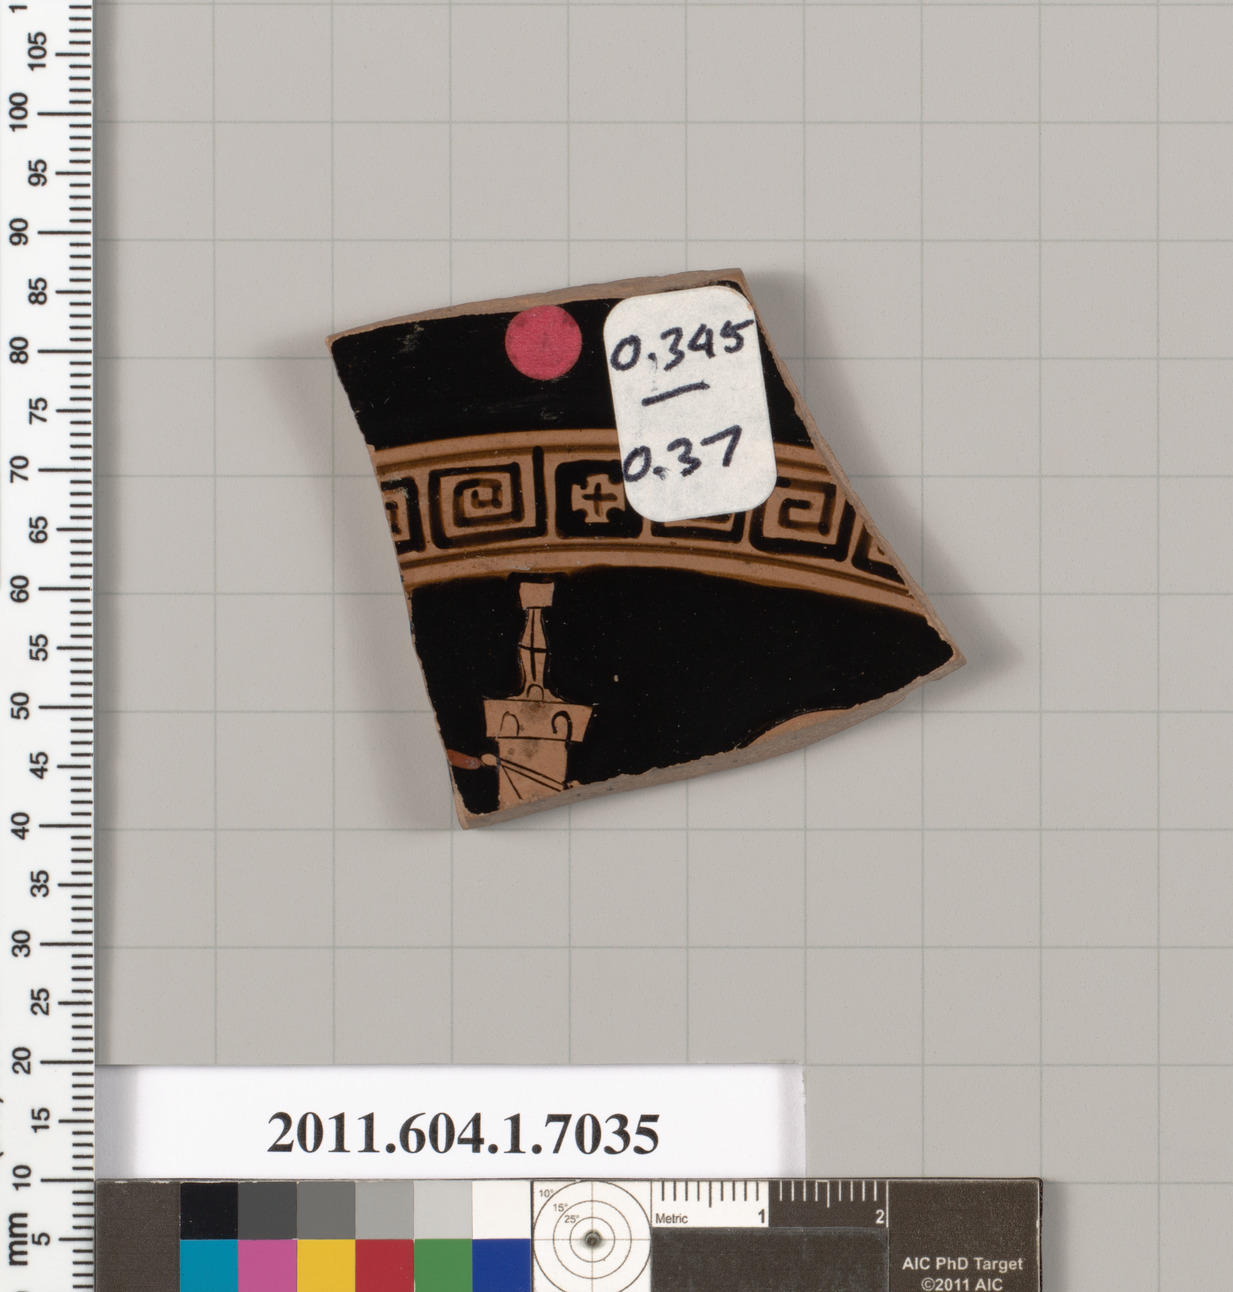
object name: kylix fragment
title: Terracotta fragment of a kylix (drinking cup)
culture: greek, attic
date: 500-480 BCE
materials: terracotta